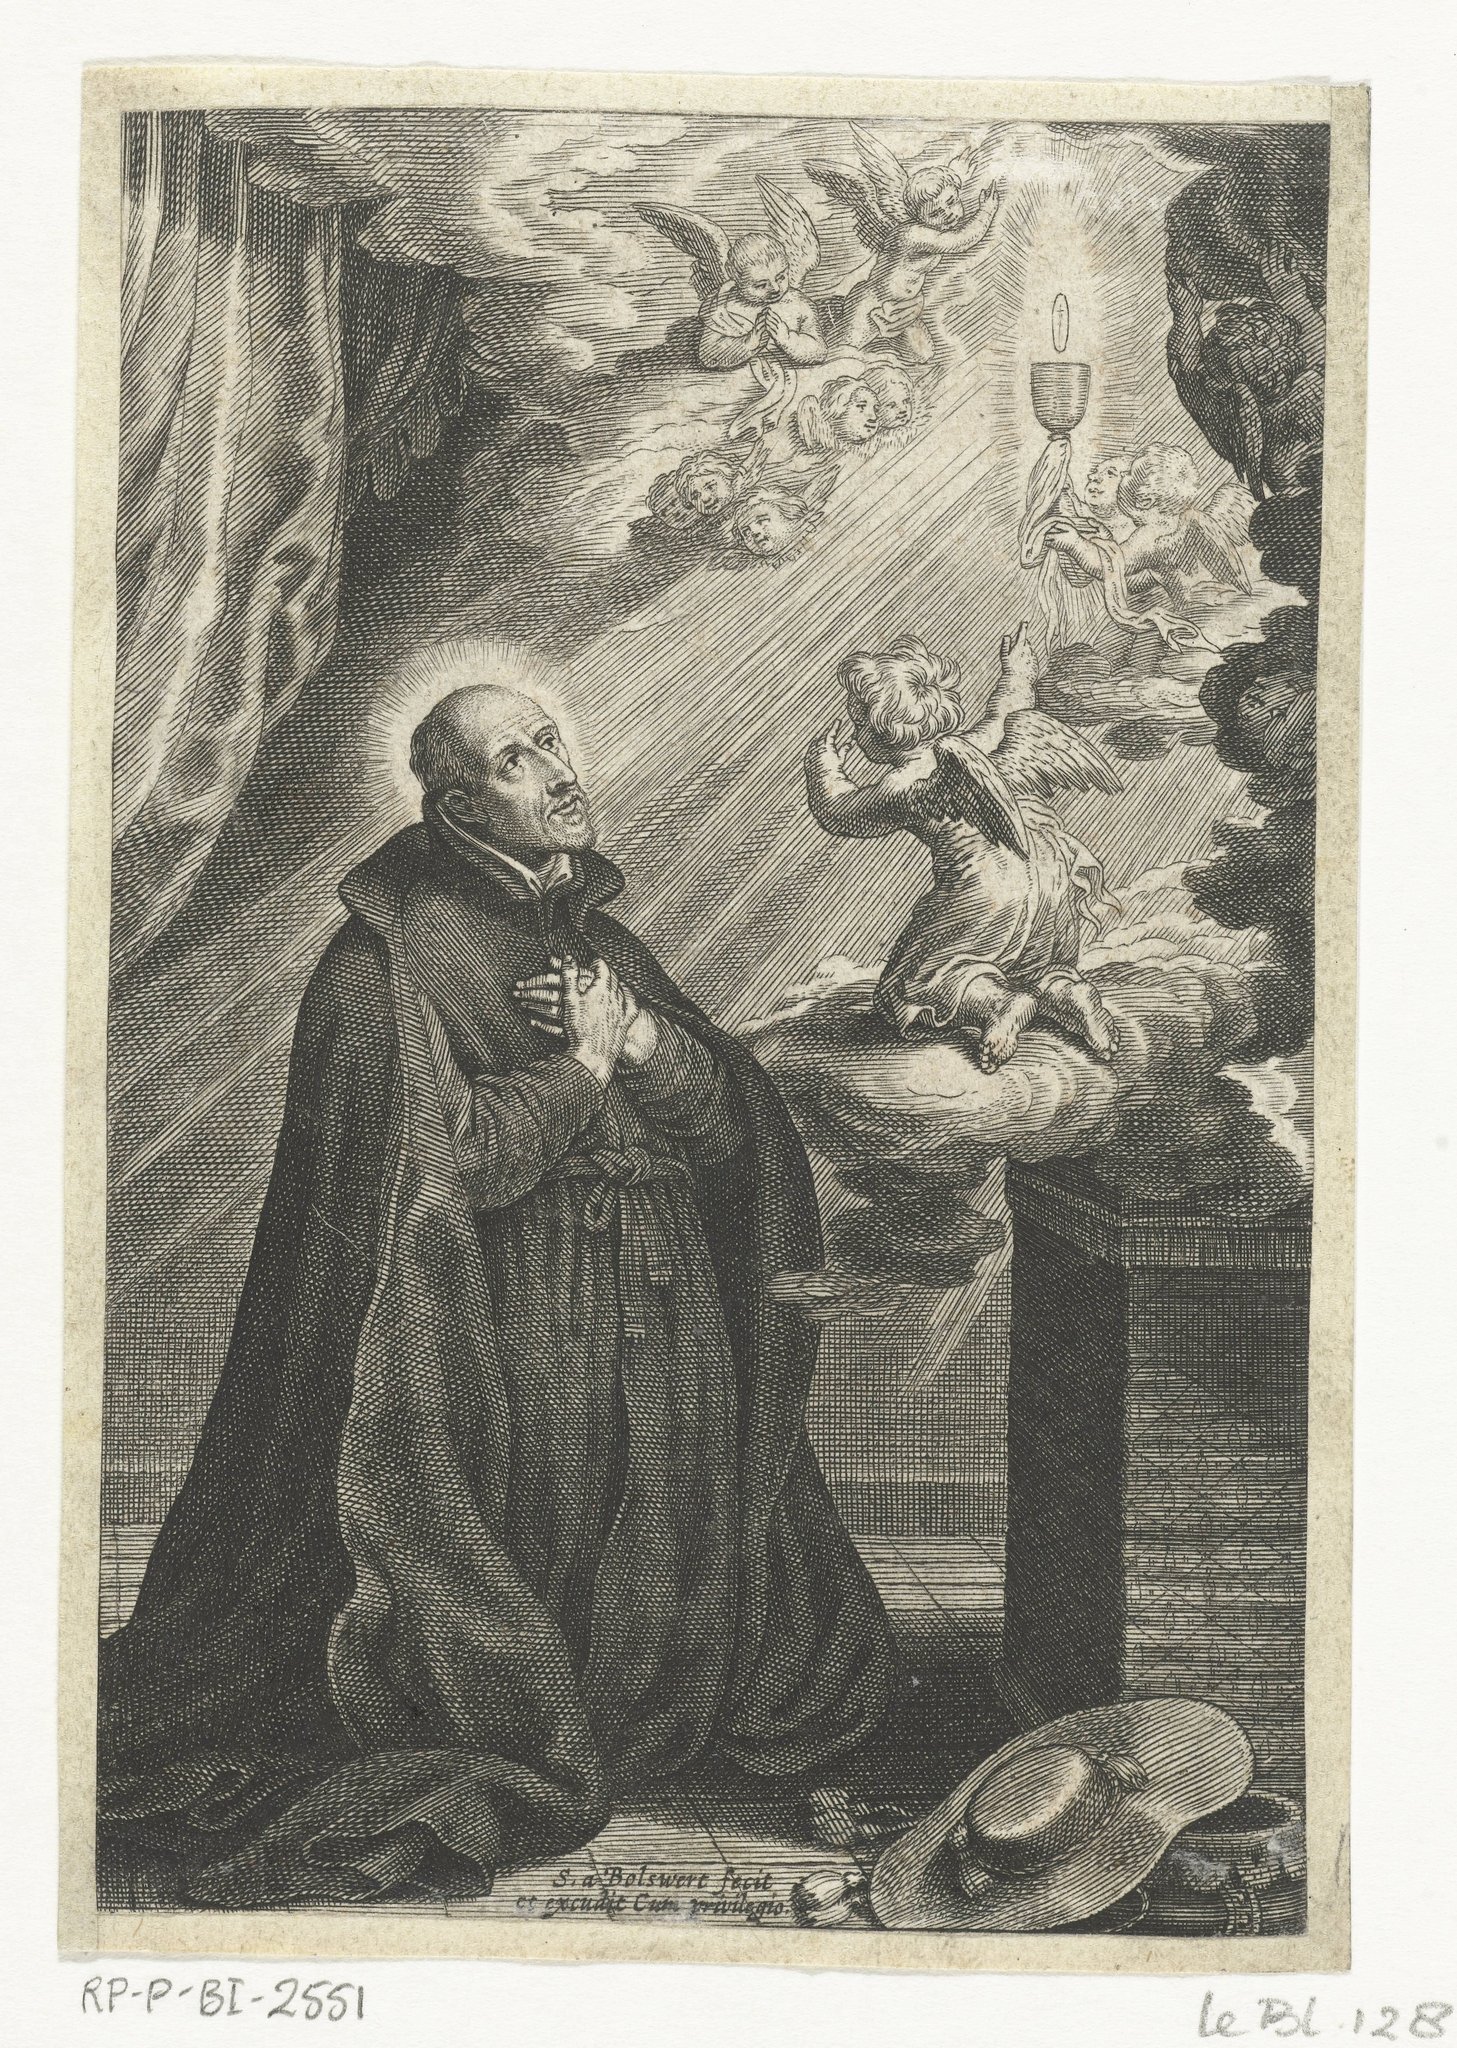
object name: print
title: Heilige Franciscus Borgia knielt voor visioen met hostie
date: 1596-1659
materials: paper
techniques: engraving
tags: adoration of the host, e.g. perpetual adoration, francis borgia, jesuit priest and duke of gandia; possible attributes: book, ducal hat, monstrance, skull with crown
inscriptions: collector's mark: Lugt 240